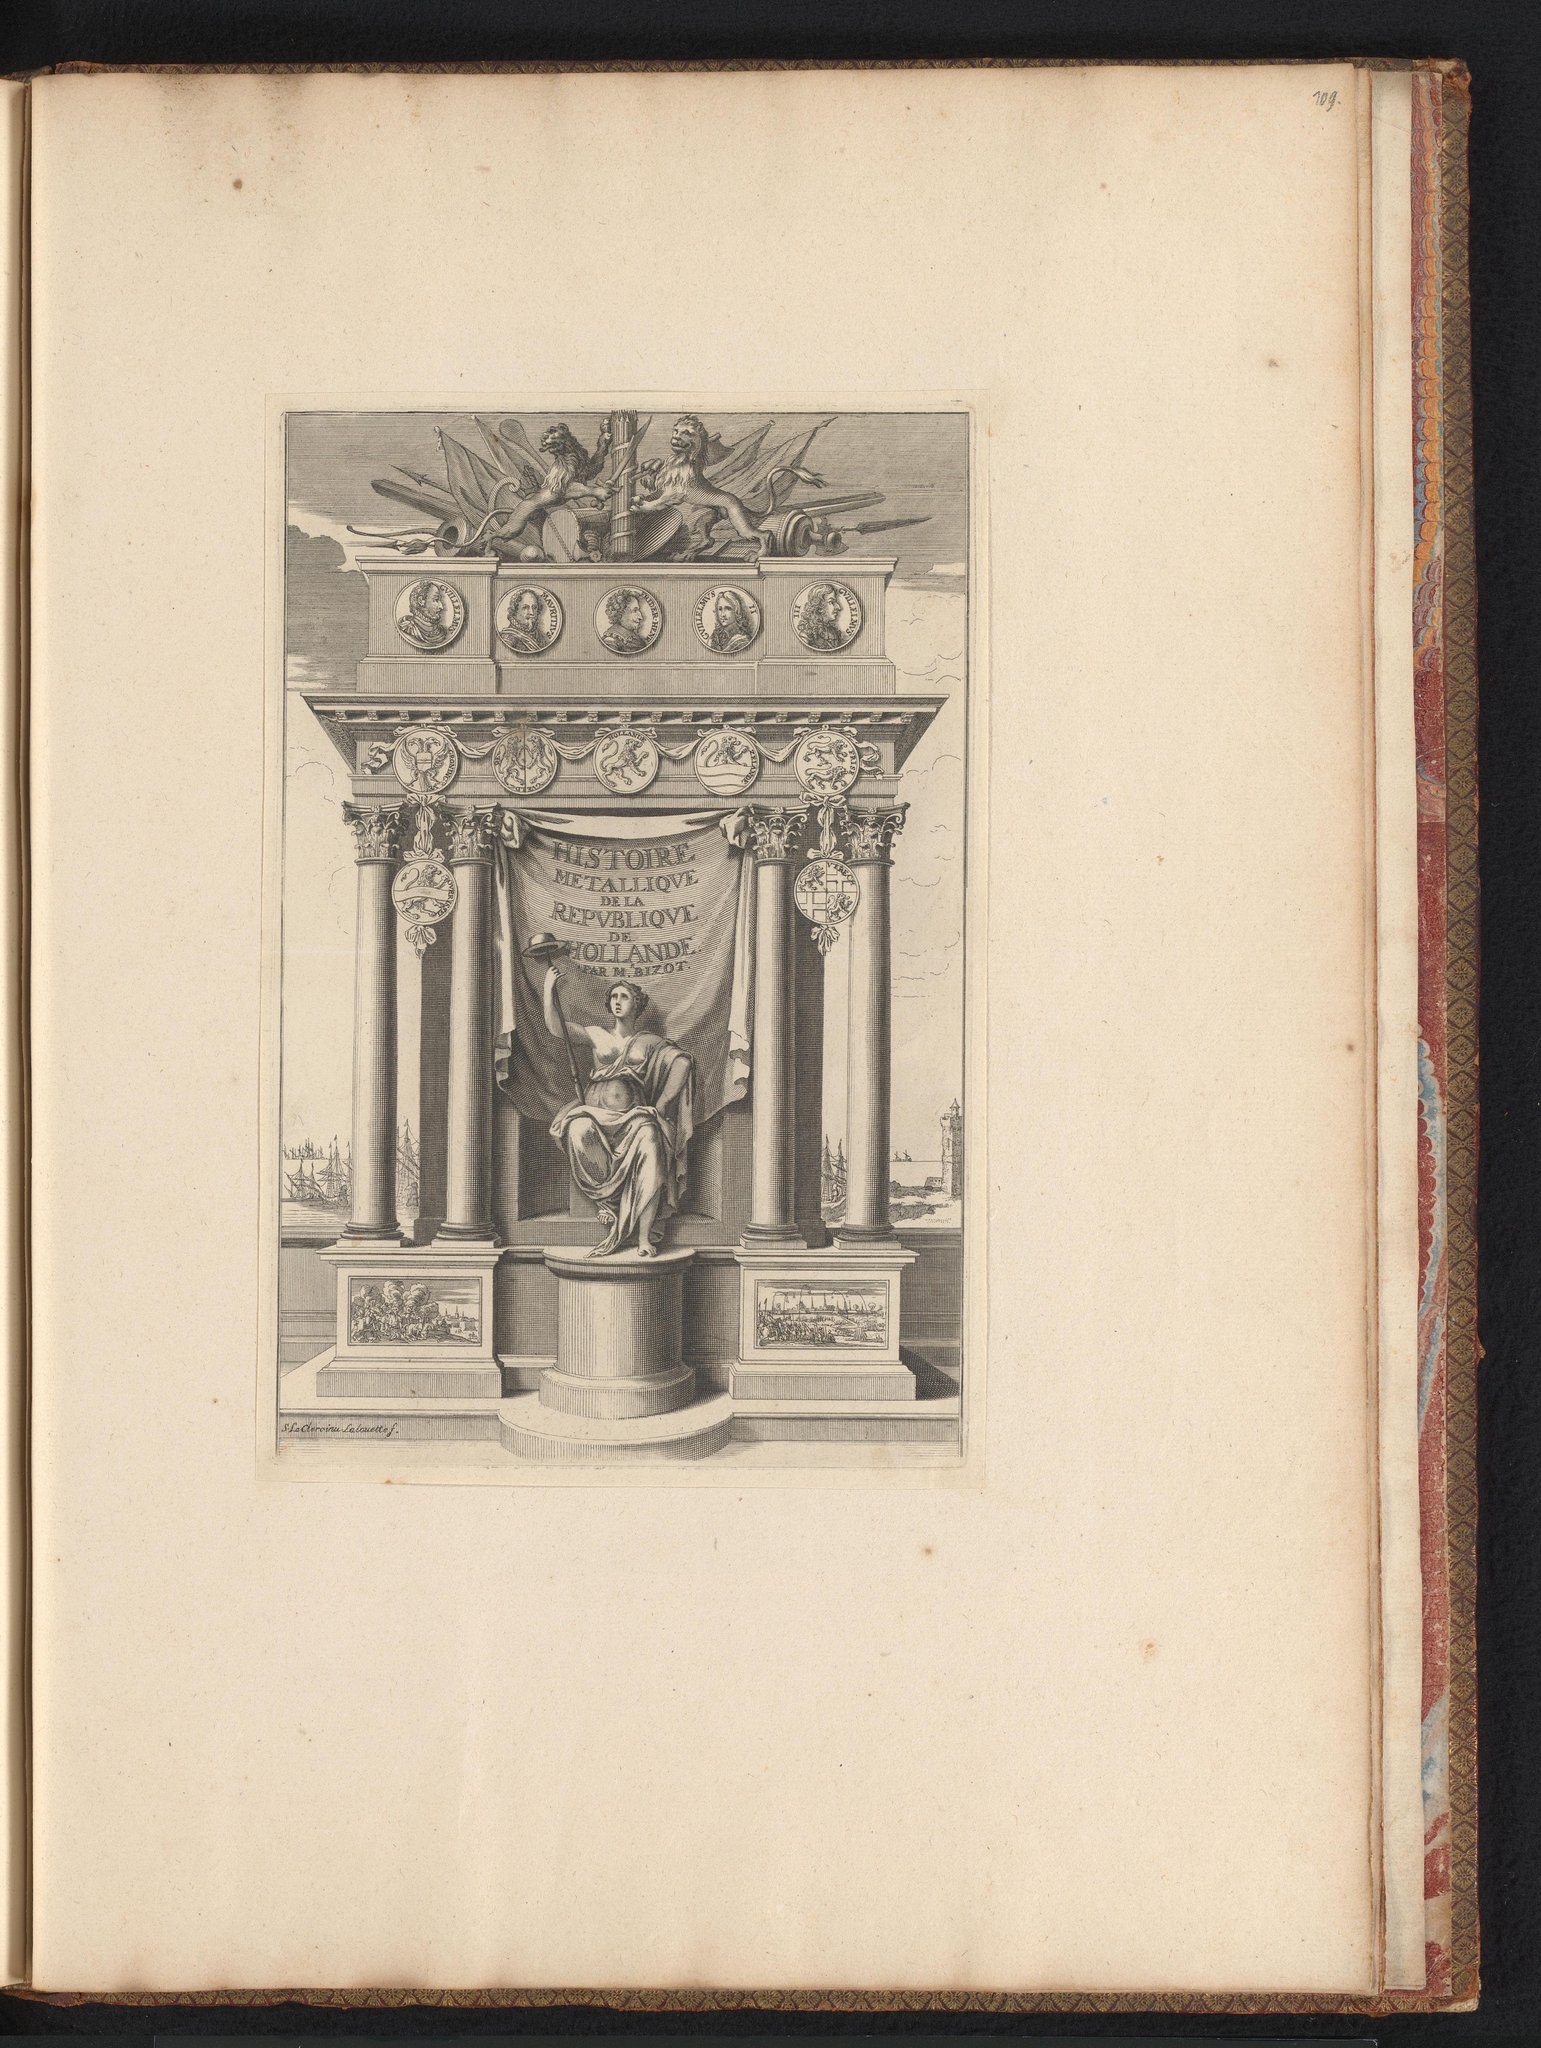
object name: print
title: Titelpagina voor: Pierre Bizot, Histoire Métallique de la République de Hollande, 1687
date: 1687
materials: paper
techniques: etching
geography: amsterdam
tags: medal (considered as a piece of sculpture, regardless of its specific function), coin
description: Titelpagina voor: Bizot, Pierre. Histoire Métallique de la République de Hollande. Amsterdam: Pieter Mortier (I), 1687.